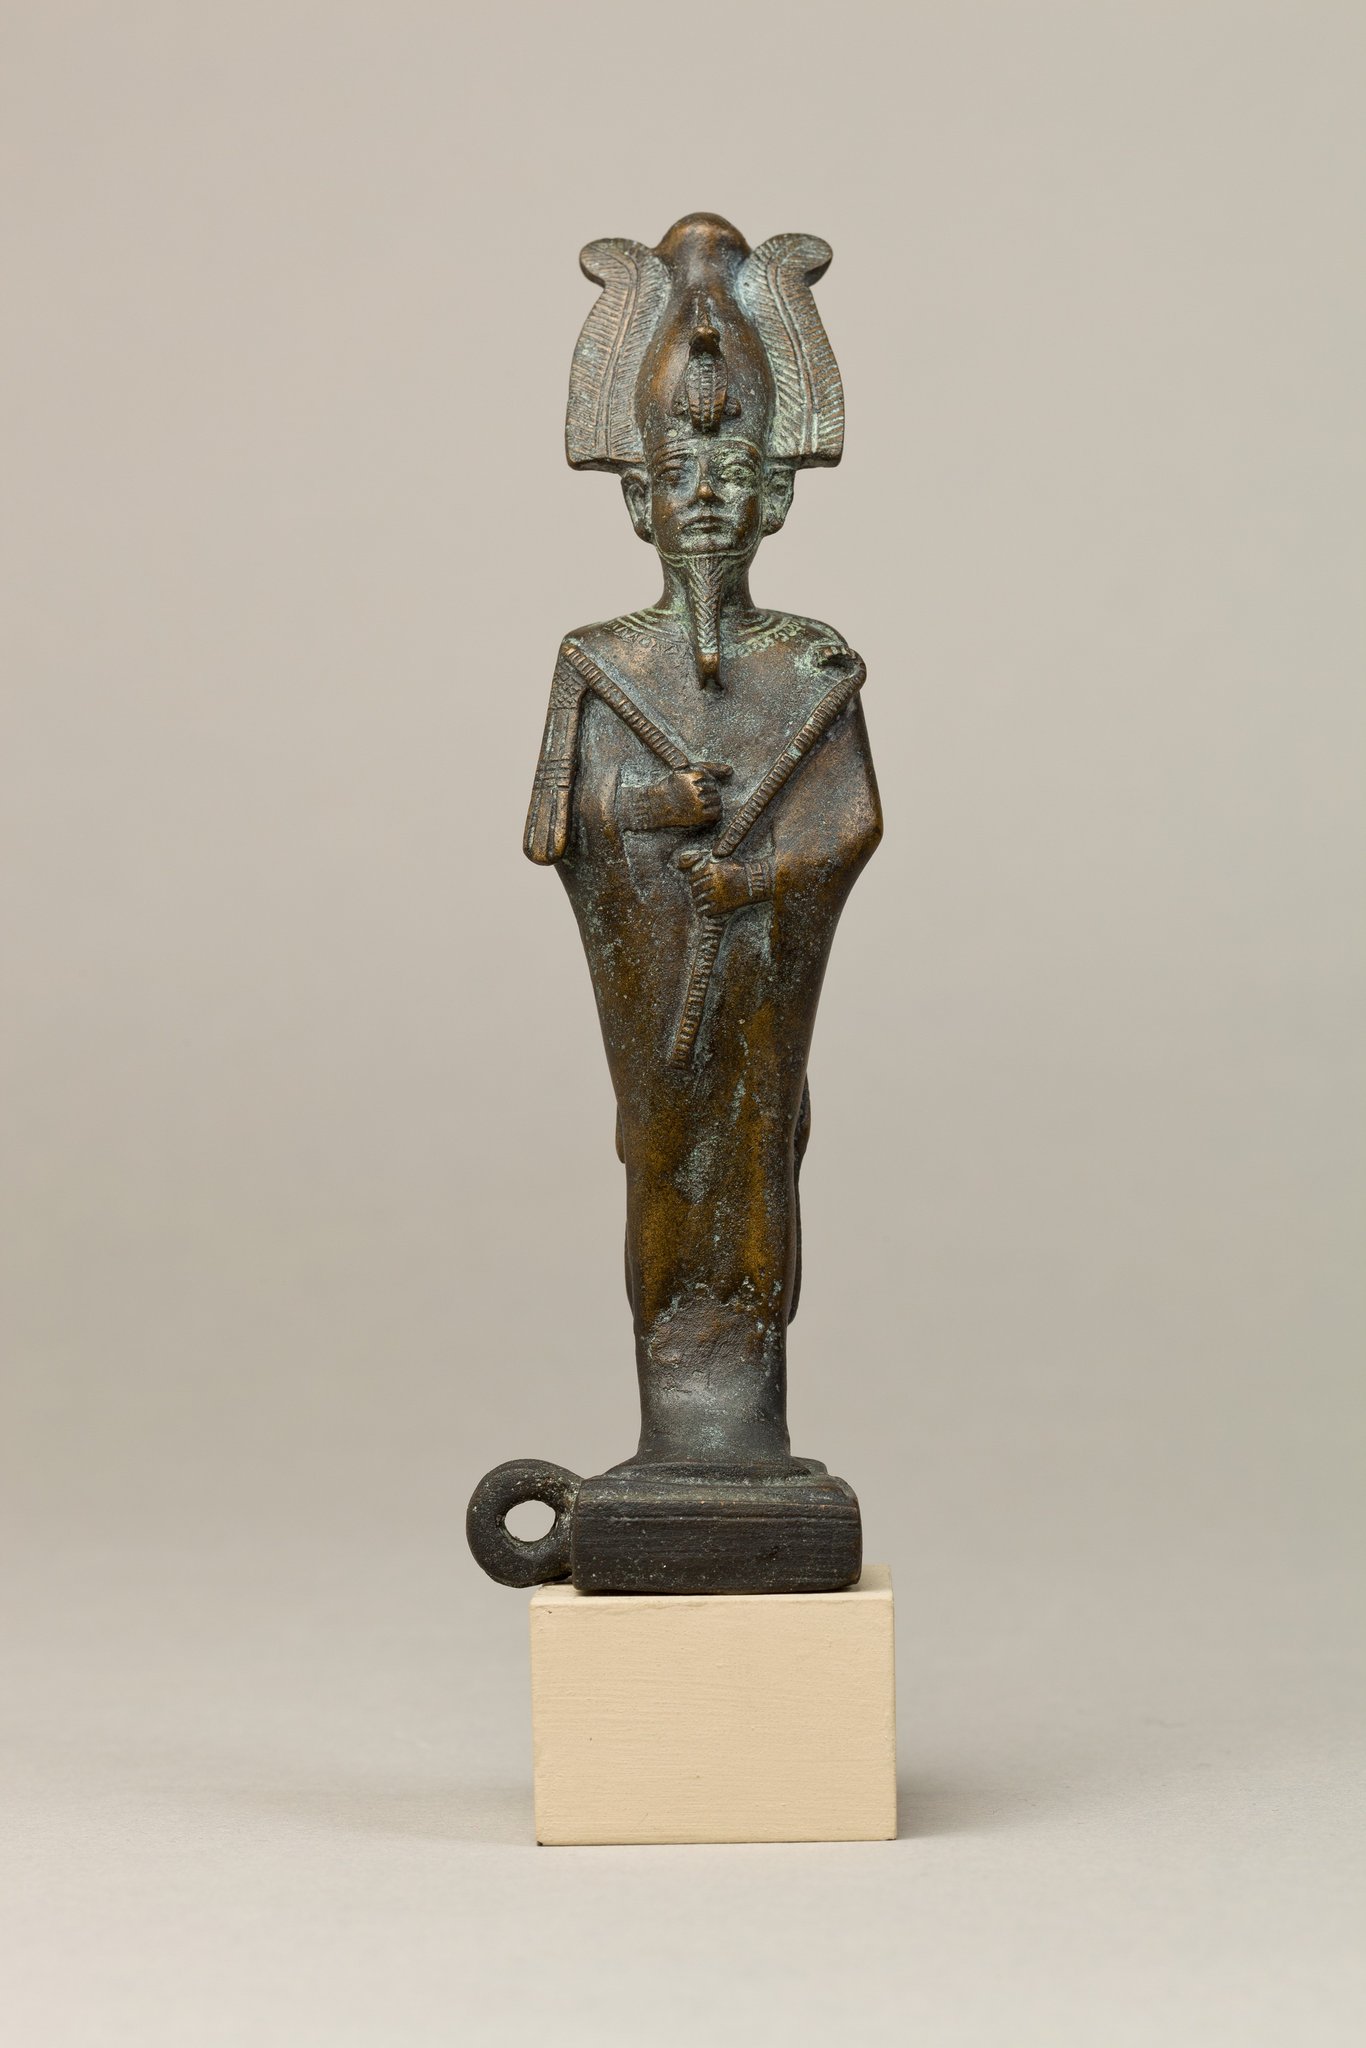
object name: statuette, osiris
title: Osiris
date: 664-630 BCE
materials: metal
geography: egypt